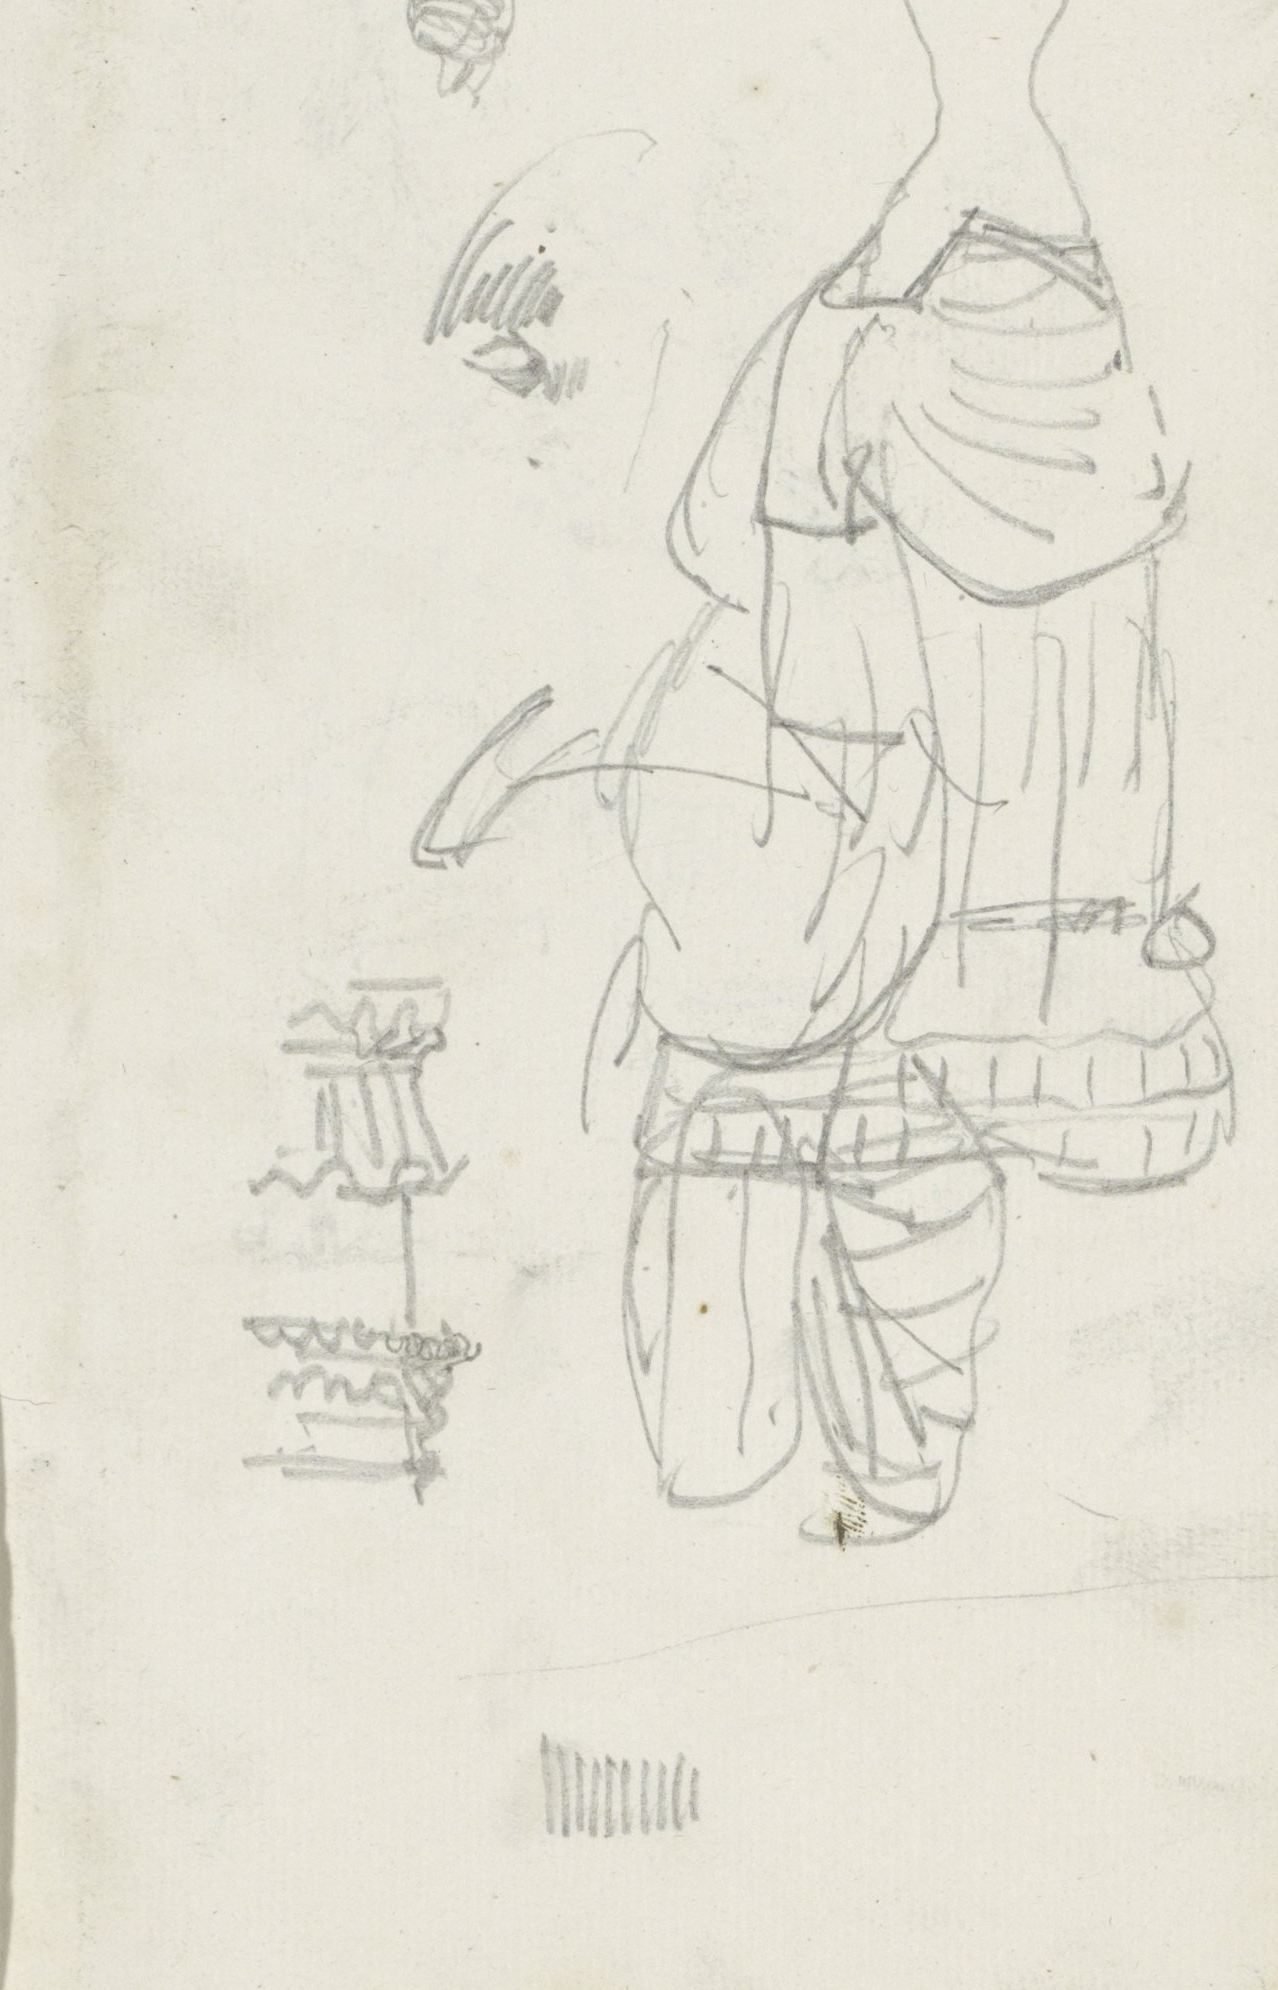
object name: sketchbook leaf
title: Kostuumstudies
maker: george hendrik breitner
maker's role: draughtsman, painter, print maker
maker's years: 1857-1923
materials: paper, pencil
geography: the hague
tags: clothes, costume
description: Pagina 48 uit een schetsboek met 28 bladen.